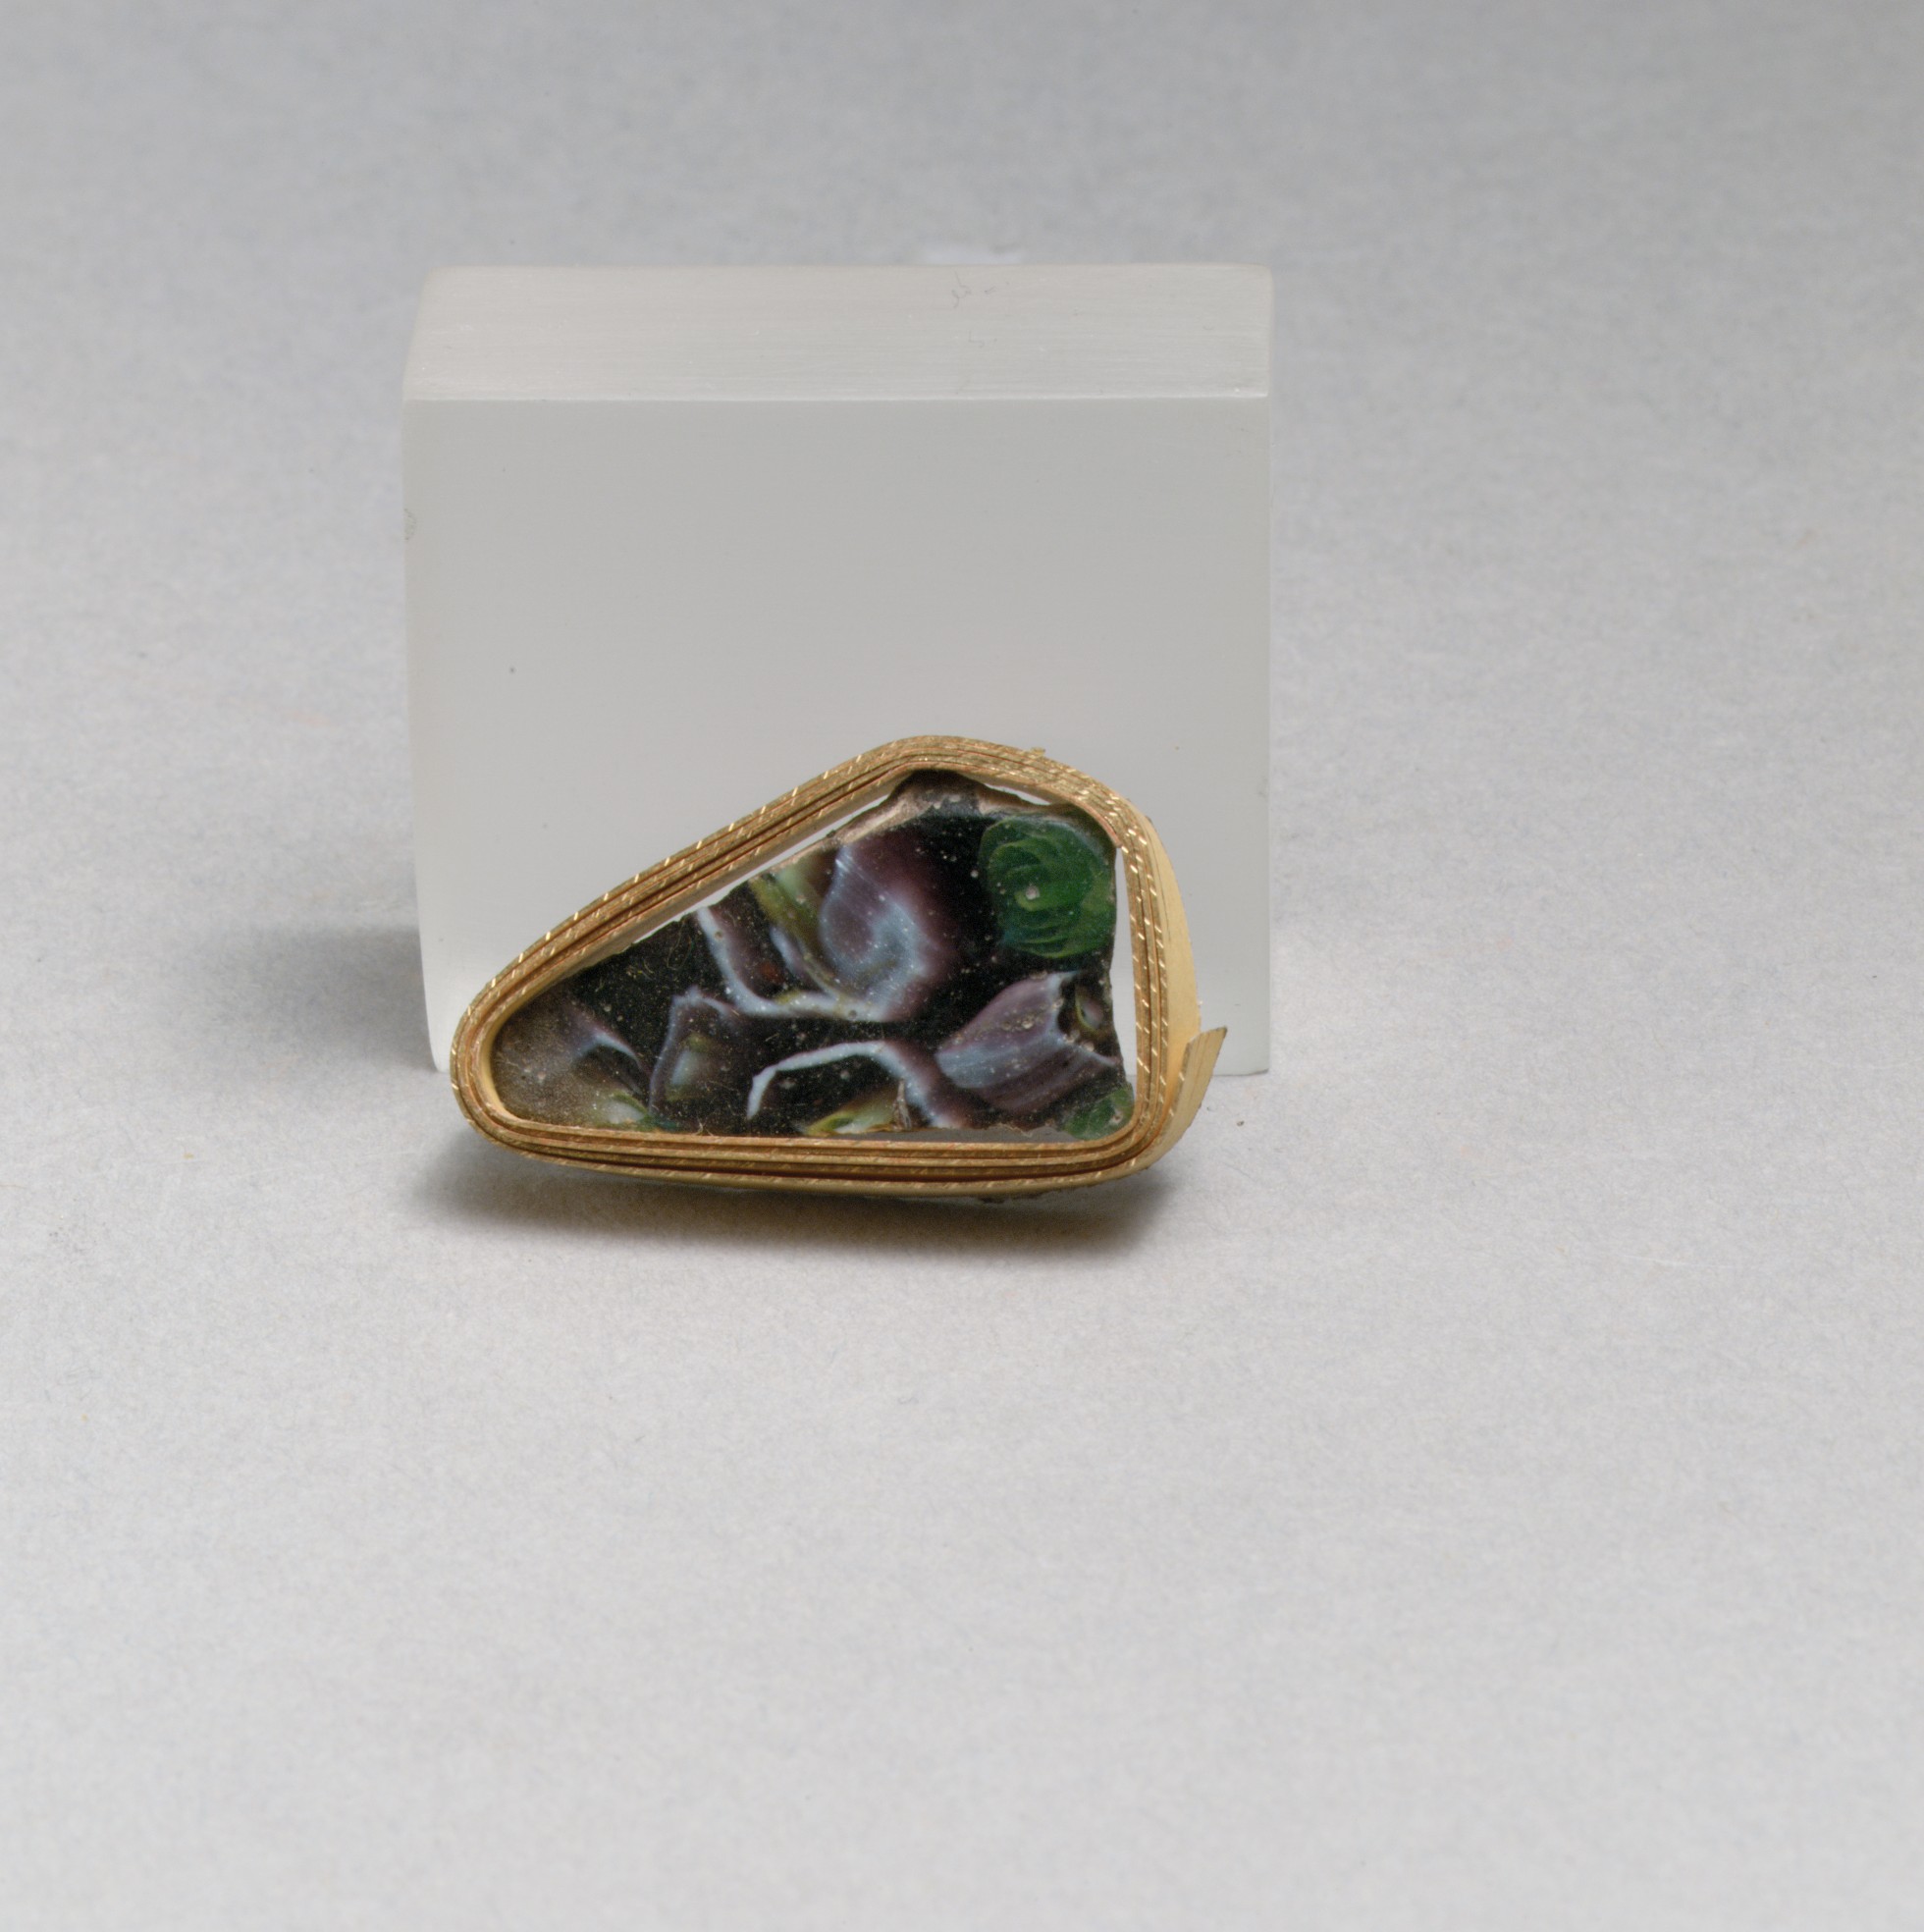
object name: fragment, mosaic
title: Glass mosaic fragment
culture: roman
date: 34 BCE-33 CE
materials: glass